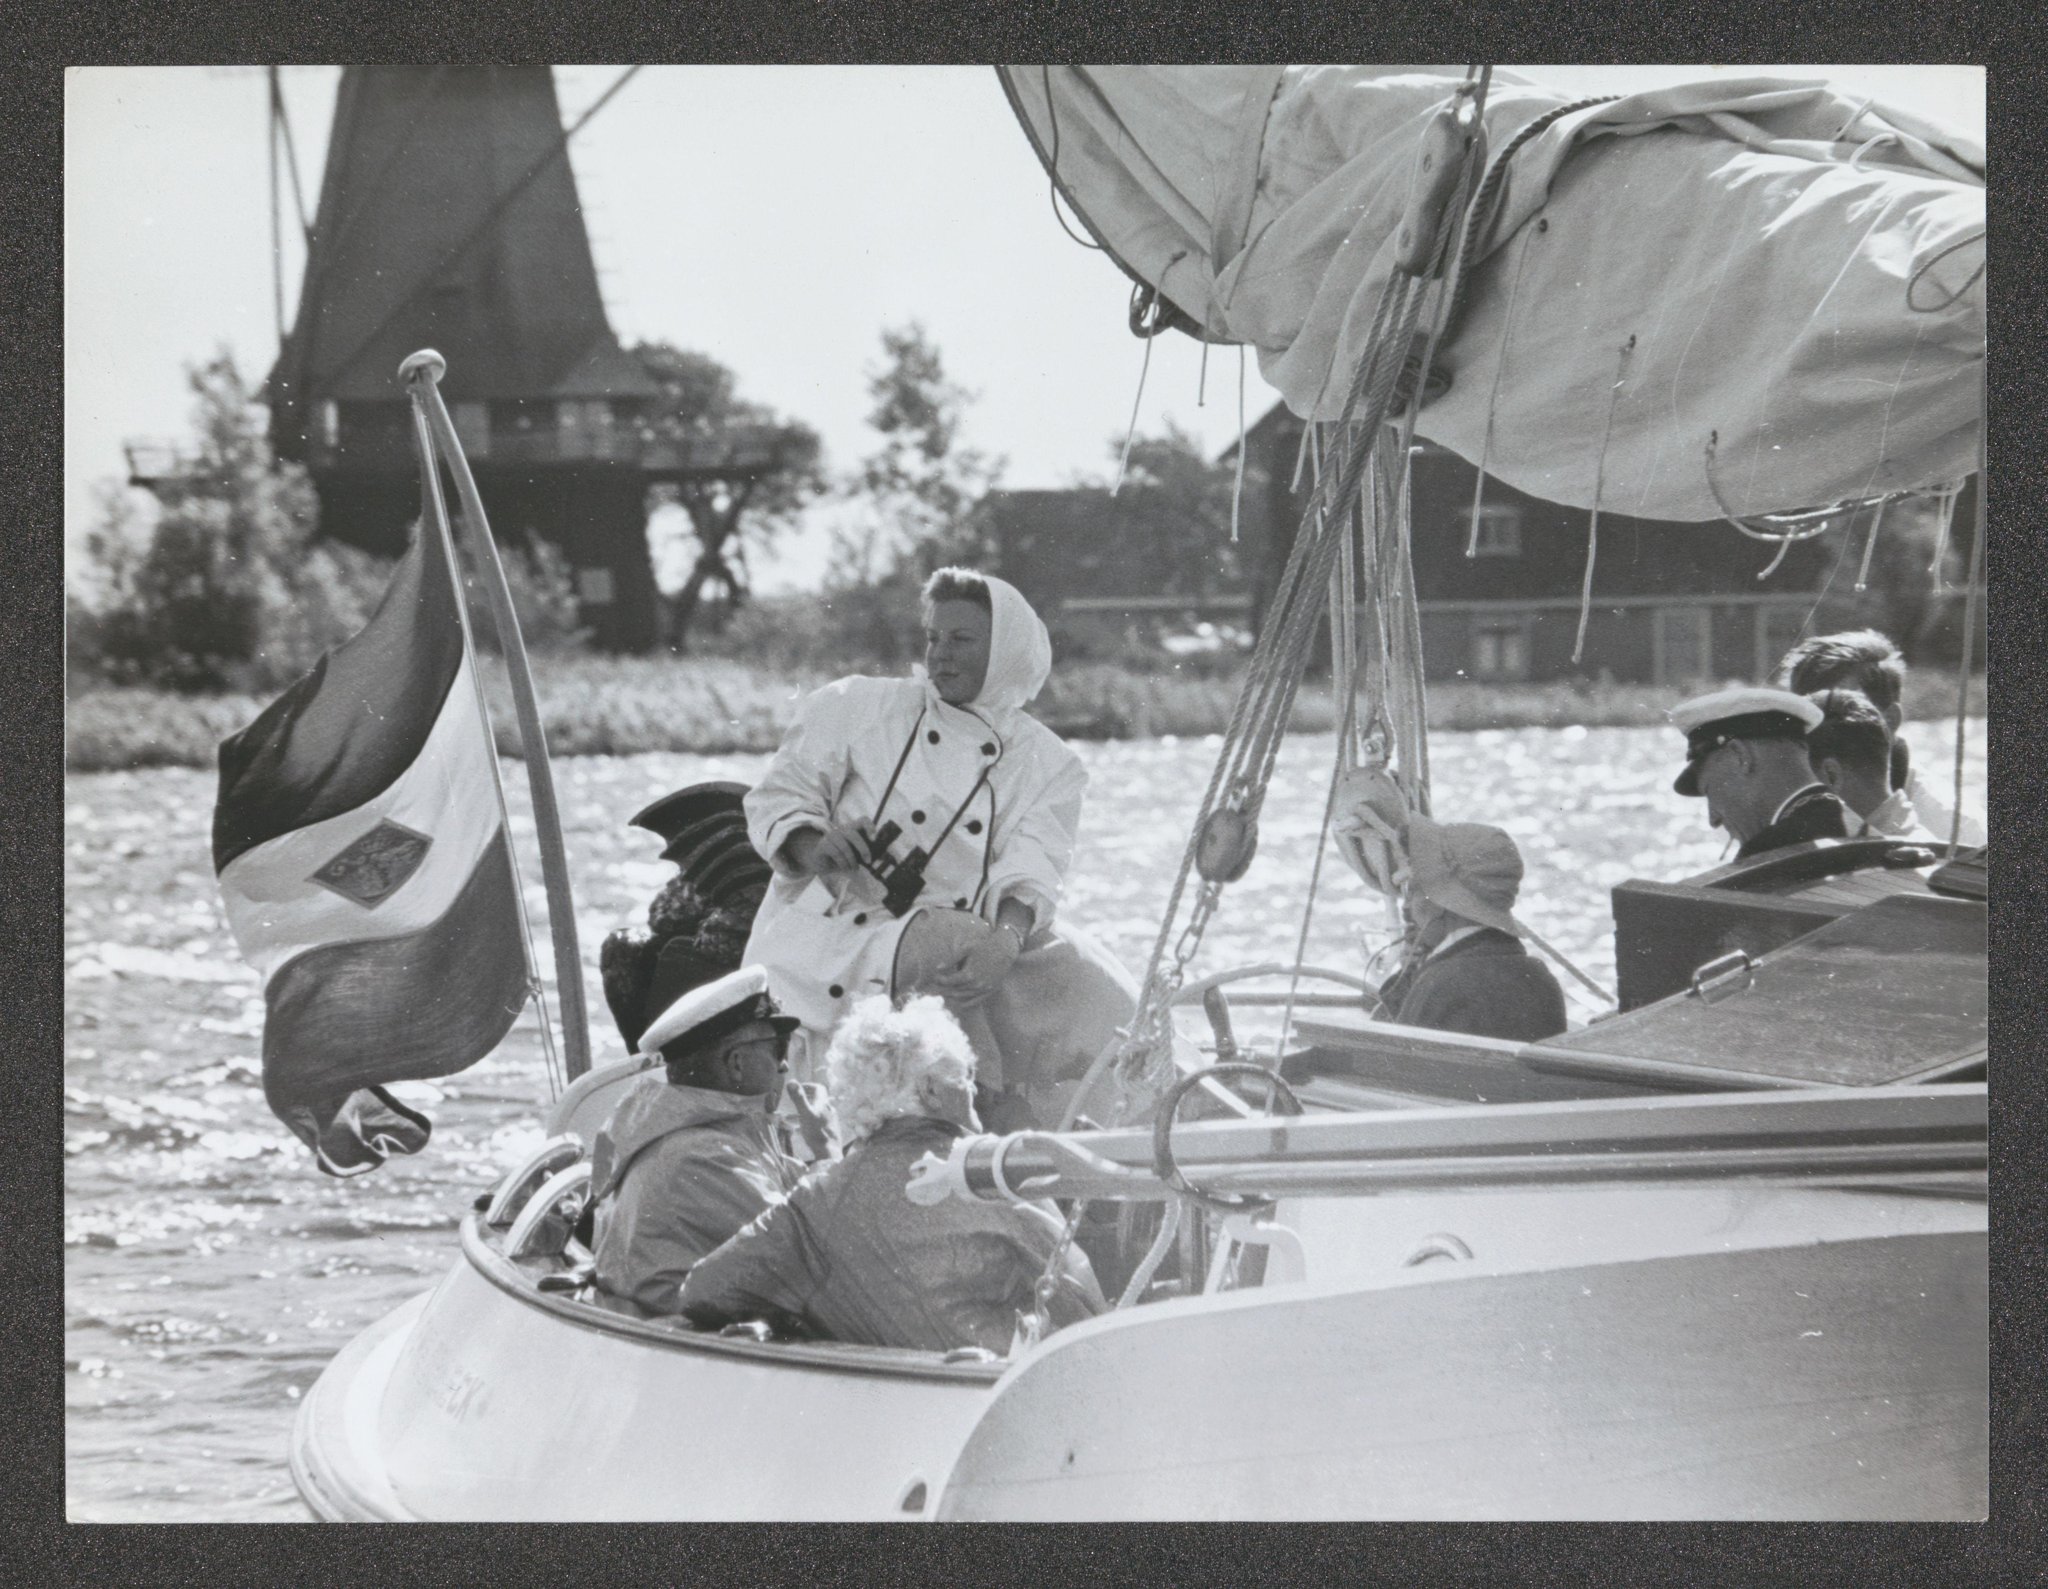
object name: photograph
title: Prinses Beatrix met verrekijker op een zeilschip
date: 1959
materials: paper, photographic support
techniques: gelatin silver print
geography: netherlands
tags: beatrix (koningin der nederlanden)